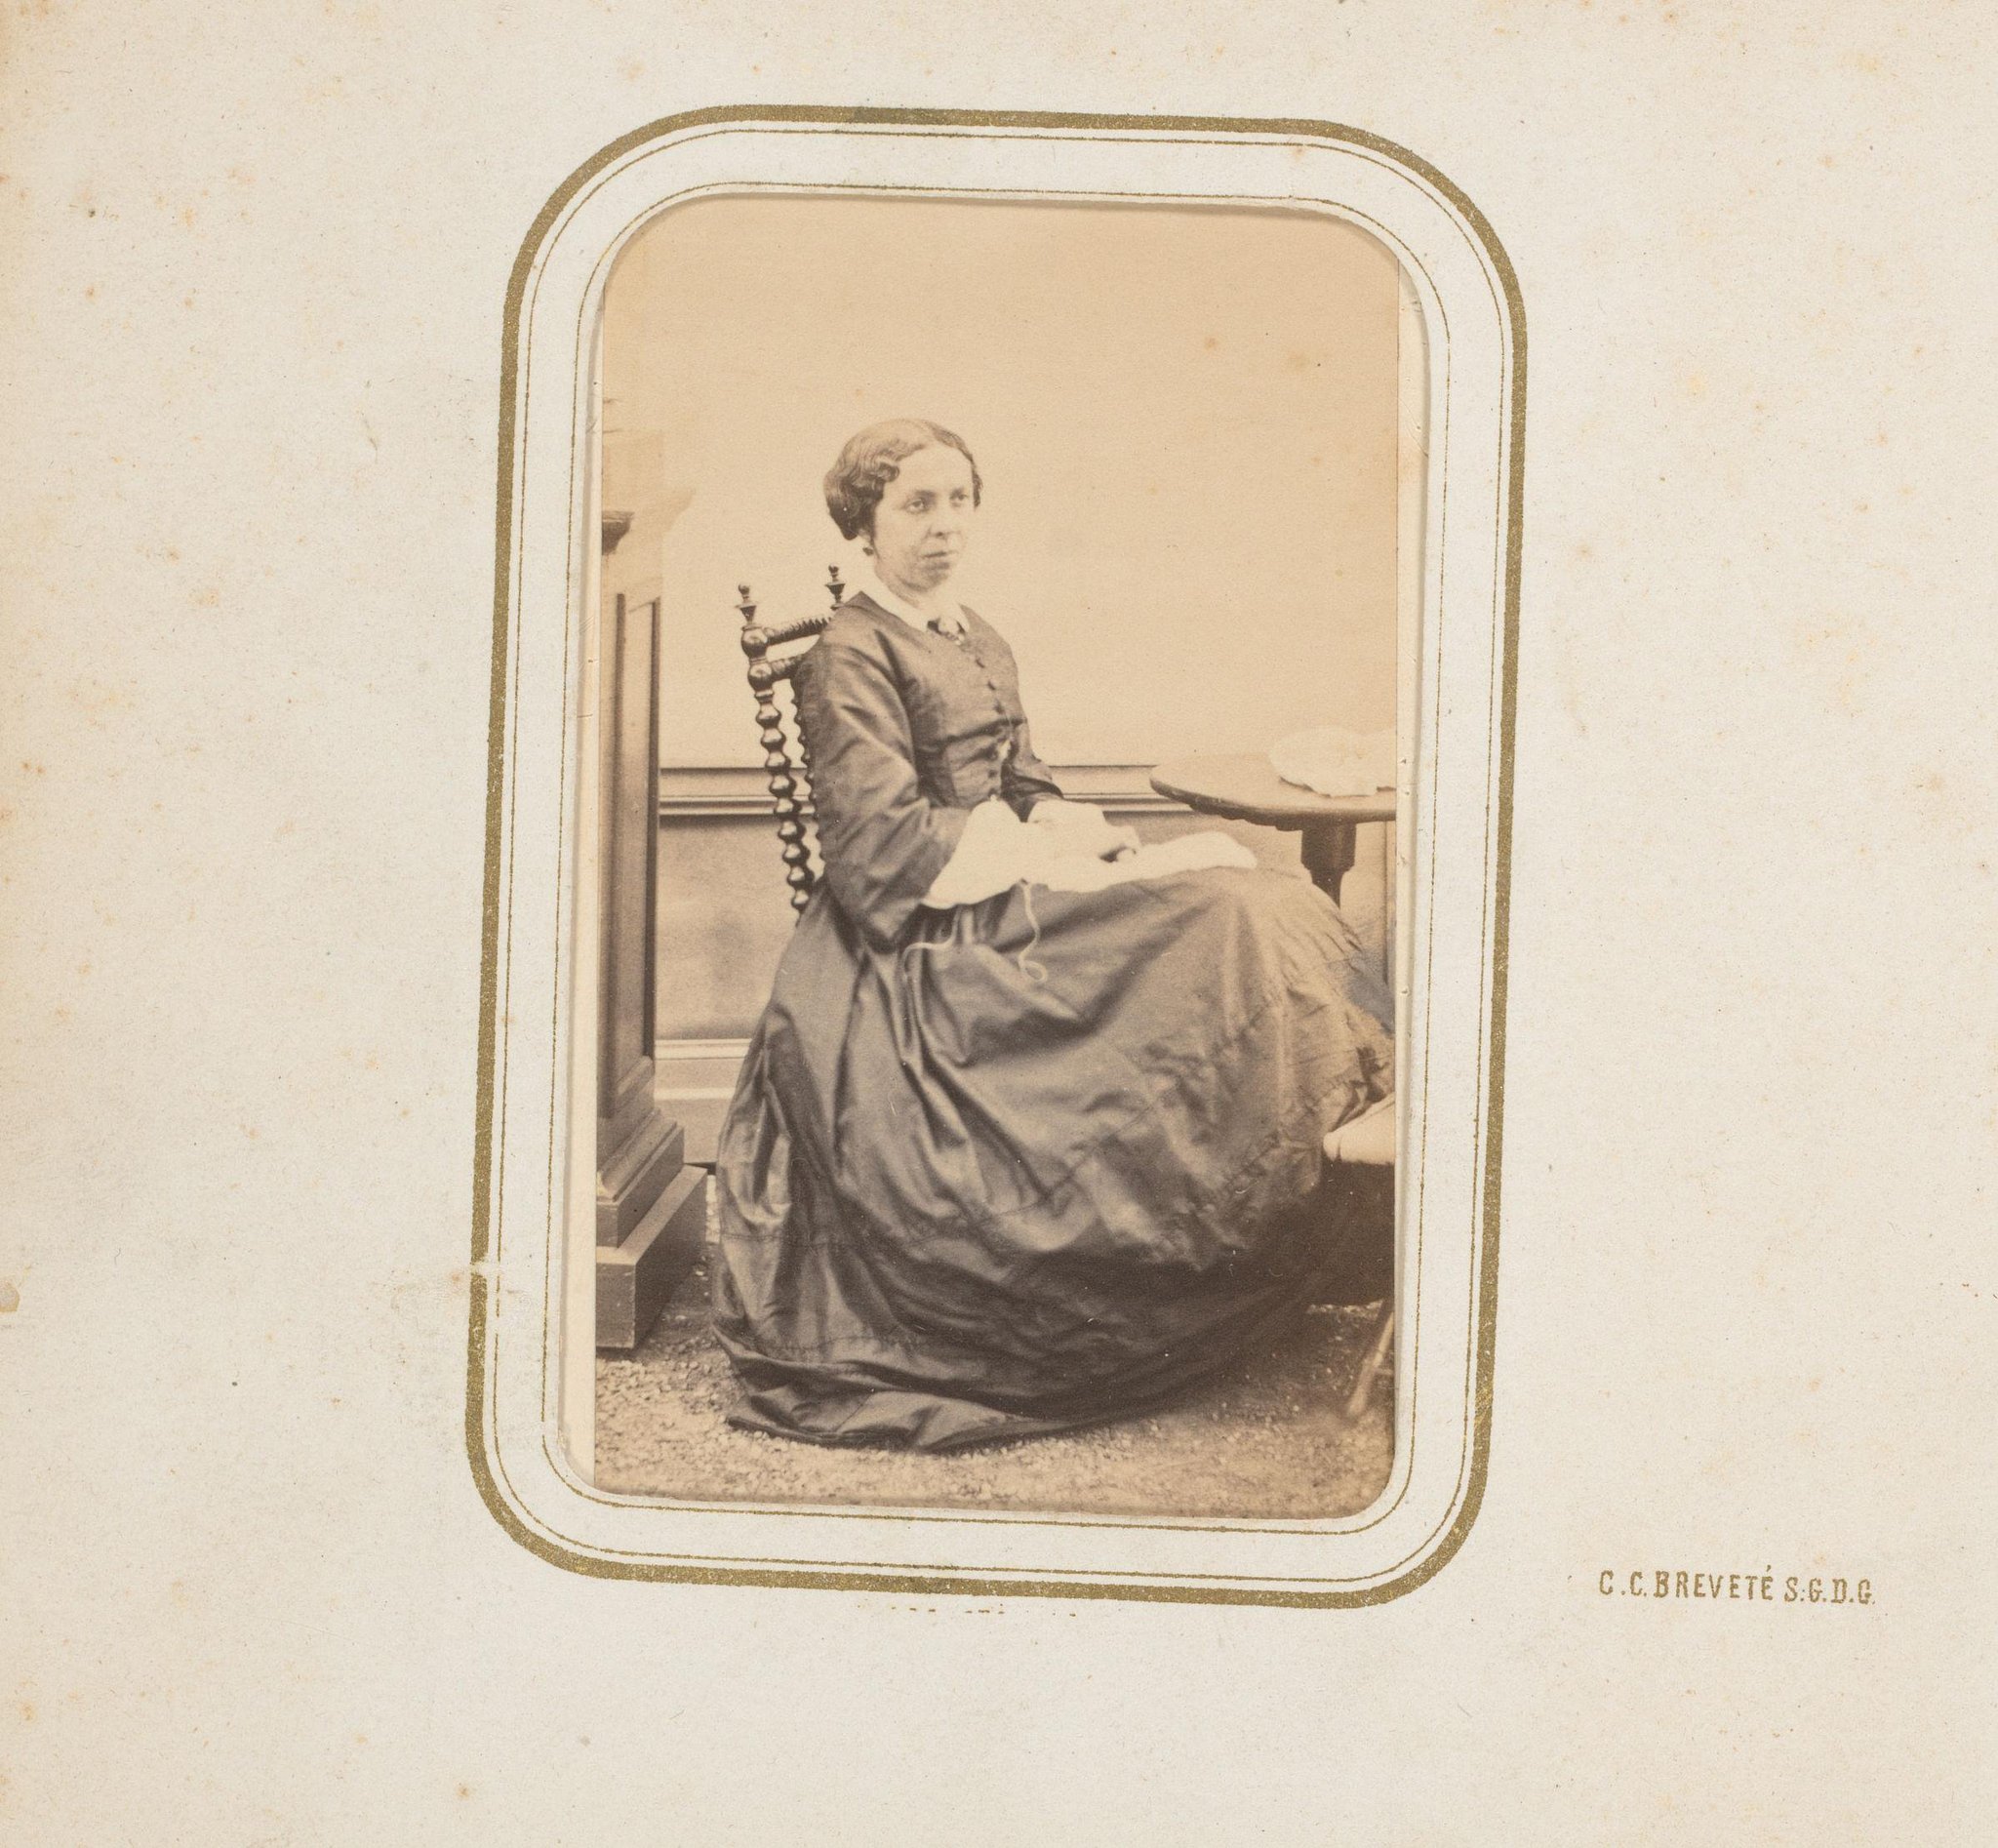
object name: carte de visite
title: Portret van een vrouw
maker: Anonymous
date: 1860-1900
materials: cardboard, photographic support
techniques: albumen print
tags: sitting figure, adult woman, historical persons